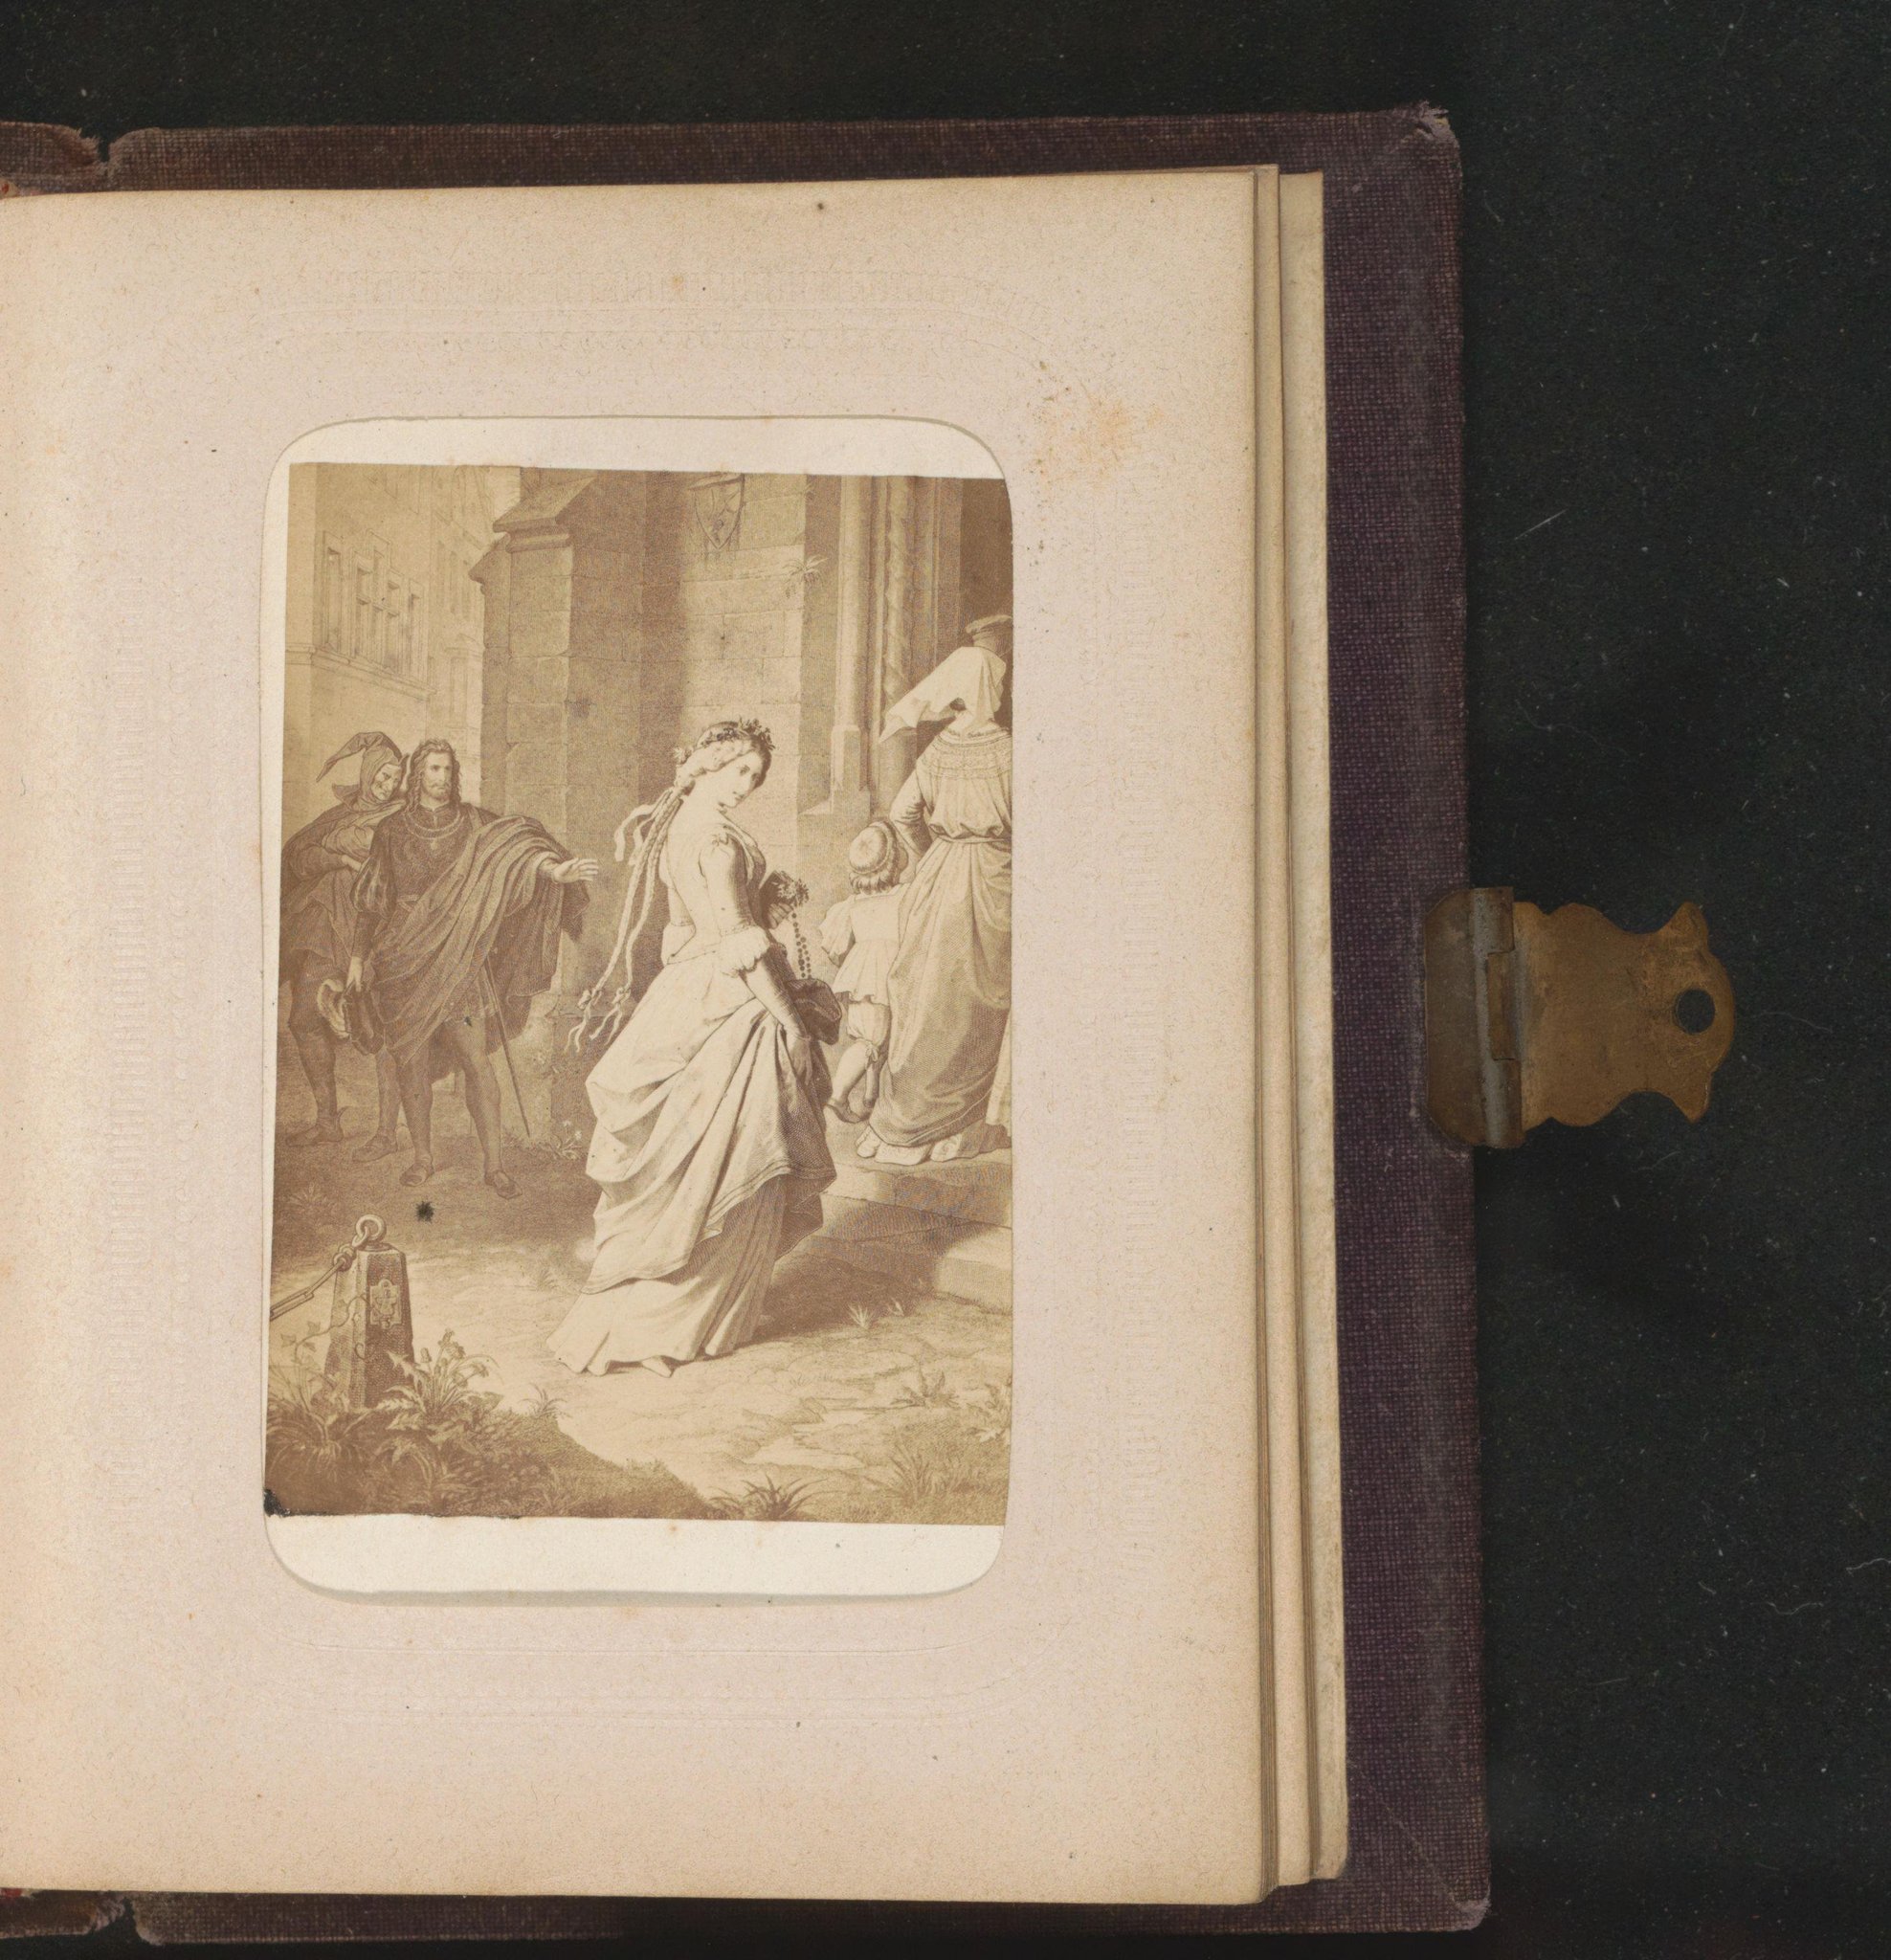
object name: carte de visite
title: Fotoreproductie van (vermoedelijk) een prent naar werk van W. von Kaulbach: Gretchen (Kirchgang) (Faust)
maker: andries jager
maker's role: publisher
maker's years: 1825-1905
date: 1860-1890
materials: cardboard, paper, photographic support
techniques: albumen print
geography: amsterdam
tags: adolescent, young woman, maiden, gretchen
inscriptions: address: ‘Water 110 Amsterdam’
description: Onderdeel van Fotoalbum met 16 cartes-de-visite van vrouwenfiguren uit het werk van J.W. von Goethe.